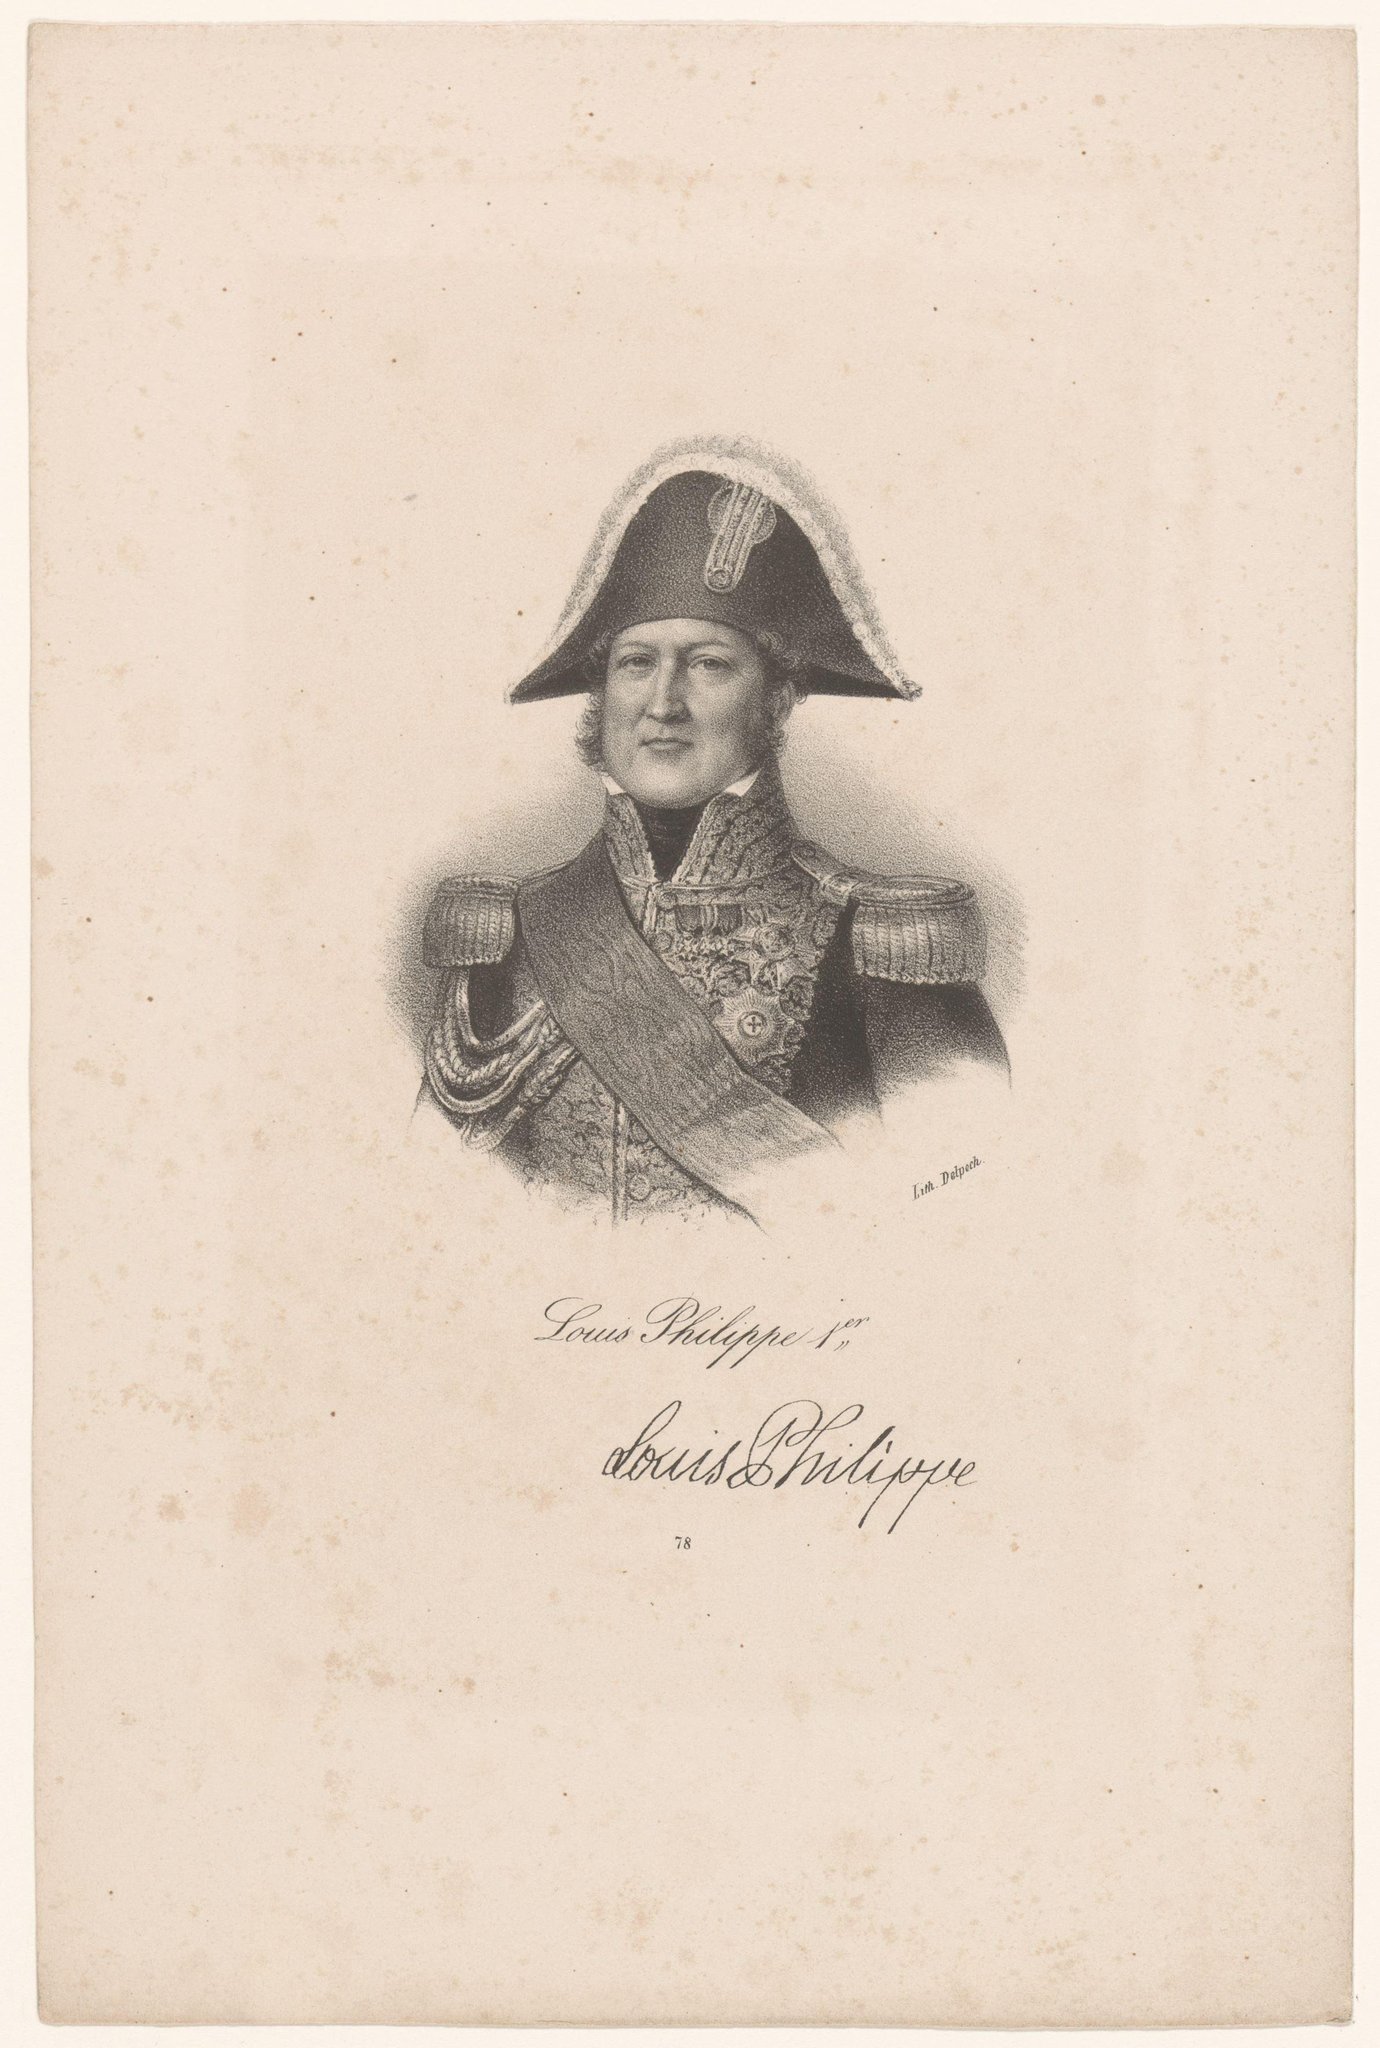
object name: print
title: Portret van Lodewijk Filips I van Frankrijk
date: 1818-1842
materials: paper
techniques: lithograph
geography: paris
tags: lodewijk filips i (koning van frankrijk), historical persons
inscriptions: collector's mark: Lugt 2228a